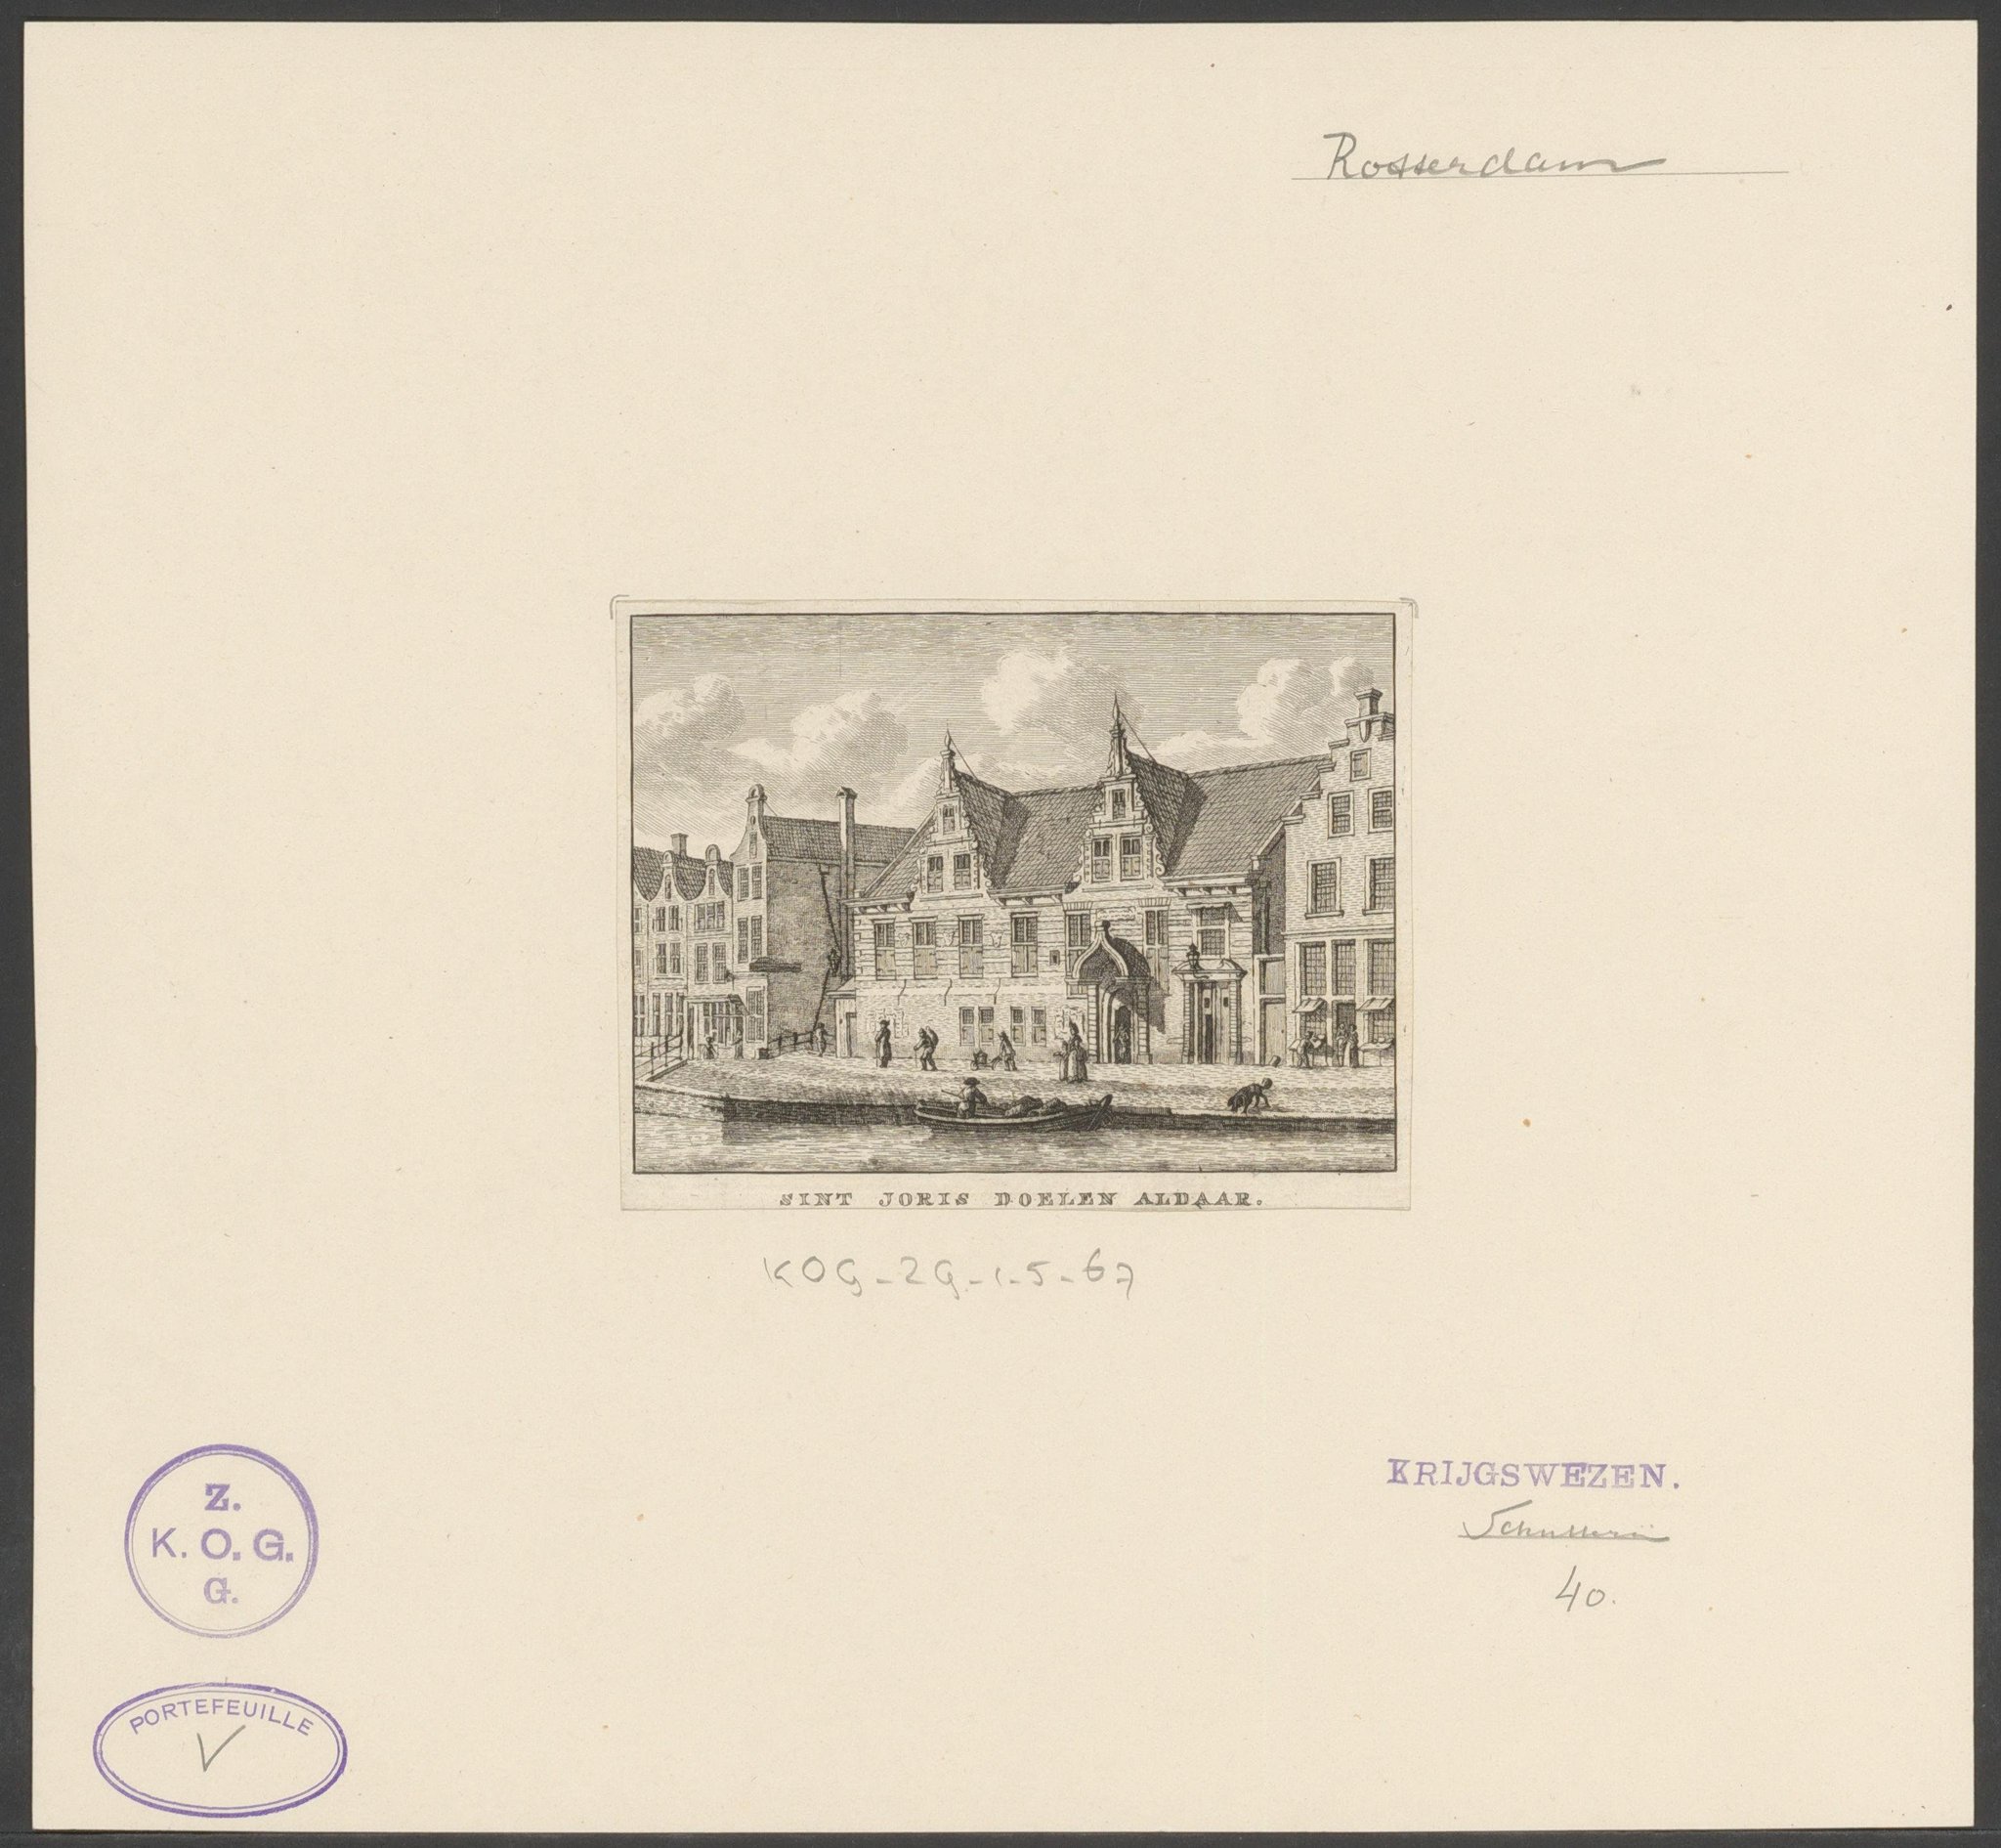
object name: print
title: Sint Joris Doelen Aldaar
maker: carel frederik bendorp (i)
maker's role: print maker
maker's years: 1736-1814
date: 1786-1792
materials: paper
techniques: etching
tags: edifice, e.g.: public building, department store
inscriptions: collector's mark: Lugt 1641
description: Prent waarschijnlijk uit: Vaderlandsche gezichten, of afbeeldingen van den tegenwoordigen staat der Vereenigde Nederlanden (…). Amsterdam: Hendrik Gartman, Willem Vermandel en Jan Willem Smit, 1786-1792. Uitgegeven in afleveringen met ieder een eigen bifolium en inhoudsopgave. Alle prenten in deze publicatie zijn gemaakt door Carel Frederik Bendorp (I) en, in de meeste gevallen, gebaseerd op tekeningen van Jan Bulthuis. Latere staat uitgegeven door Maaskamp als onderdeel van een plaatwerk uit ca. 1824-1825 met 74 (ongenummerde) platen van de belangrijkste topografische gezichten en verschillende zeden en gewoonten in het Verenigd Koninkrijk der Nederlanden.